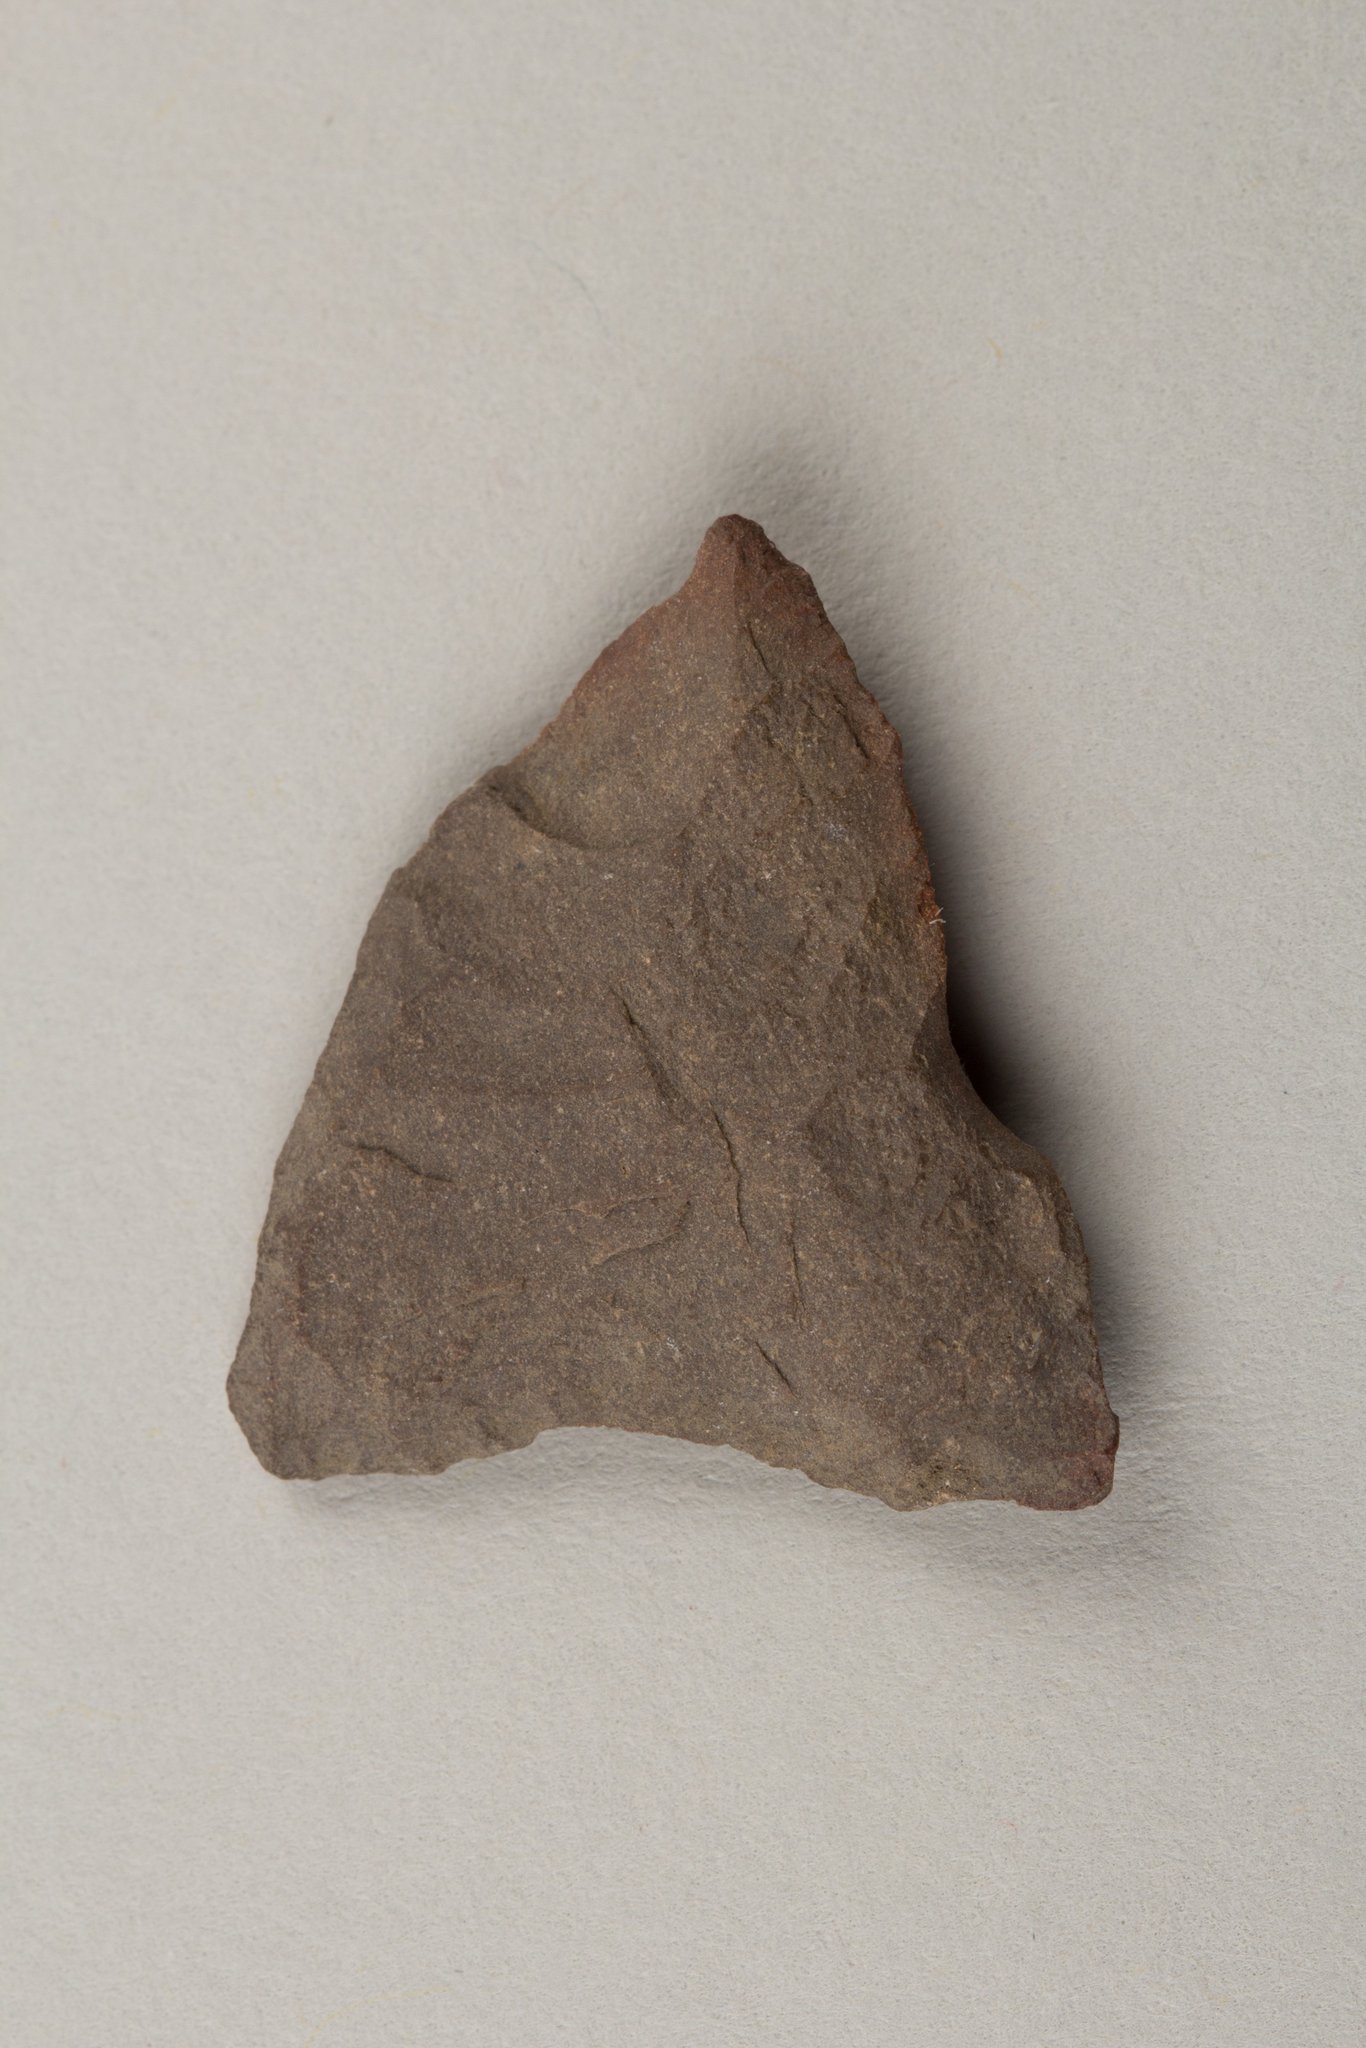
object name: arrowhead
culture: japanese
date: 1500-1000 BCE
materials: stone